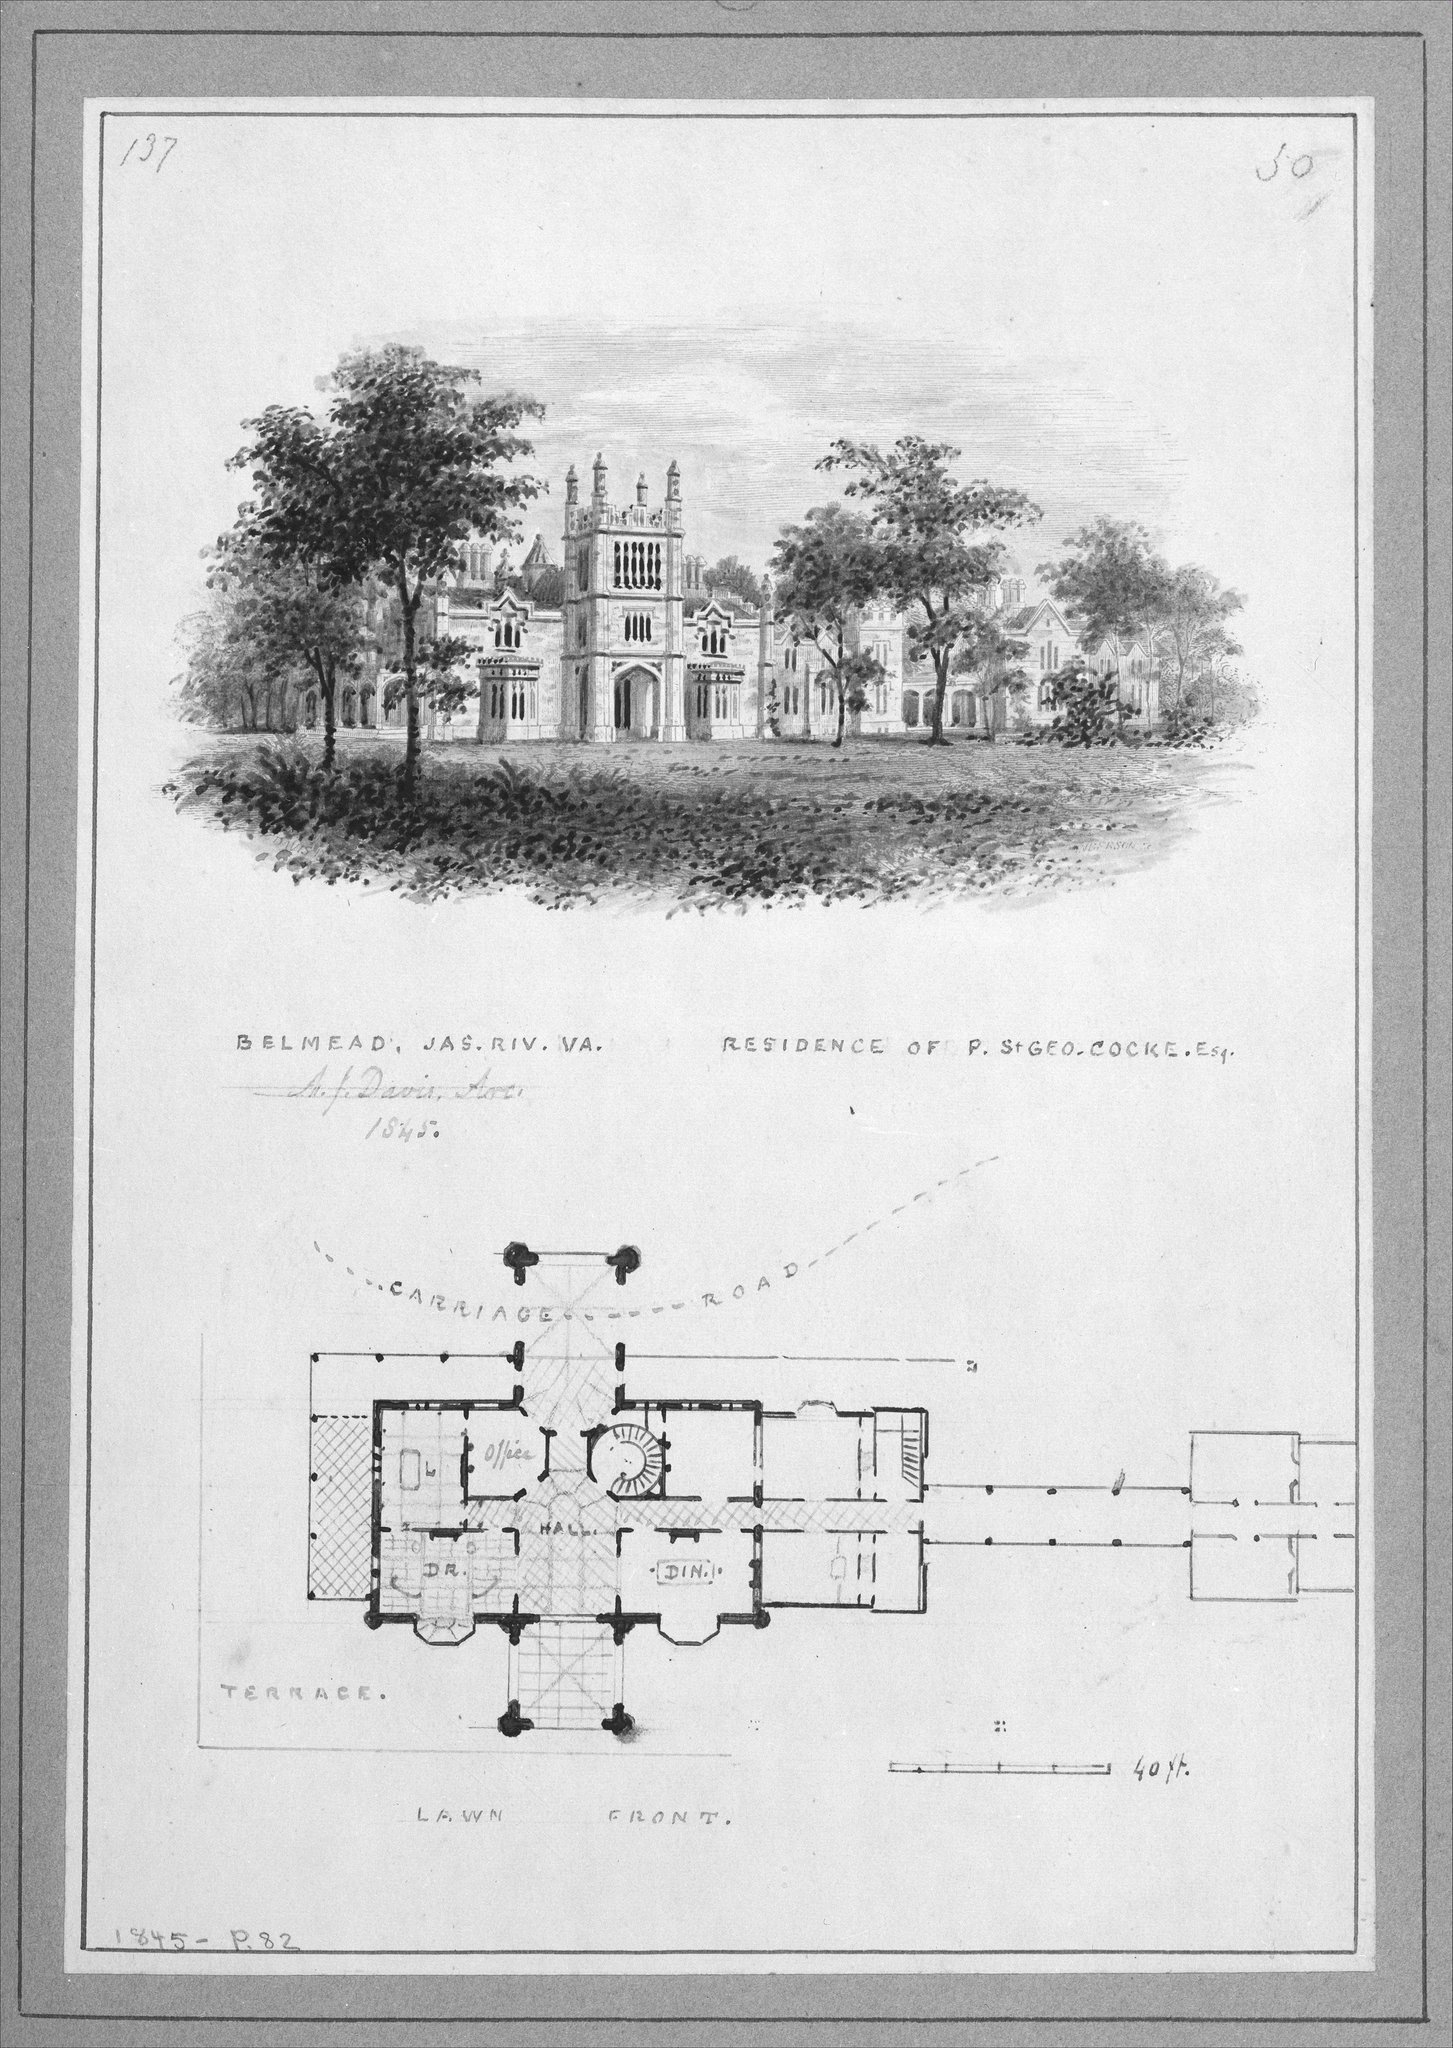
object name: drawing ornament architecture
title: "Belmead", James River, Virginia, Residence of Philip St. George Cocke (vignette of riverside elevation and plan)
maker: alexander jackson davis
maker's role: artist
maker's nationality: american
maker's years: 1803-1892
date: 1845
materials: ink, watercolor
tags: architecture,houses